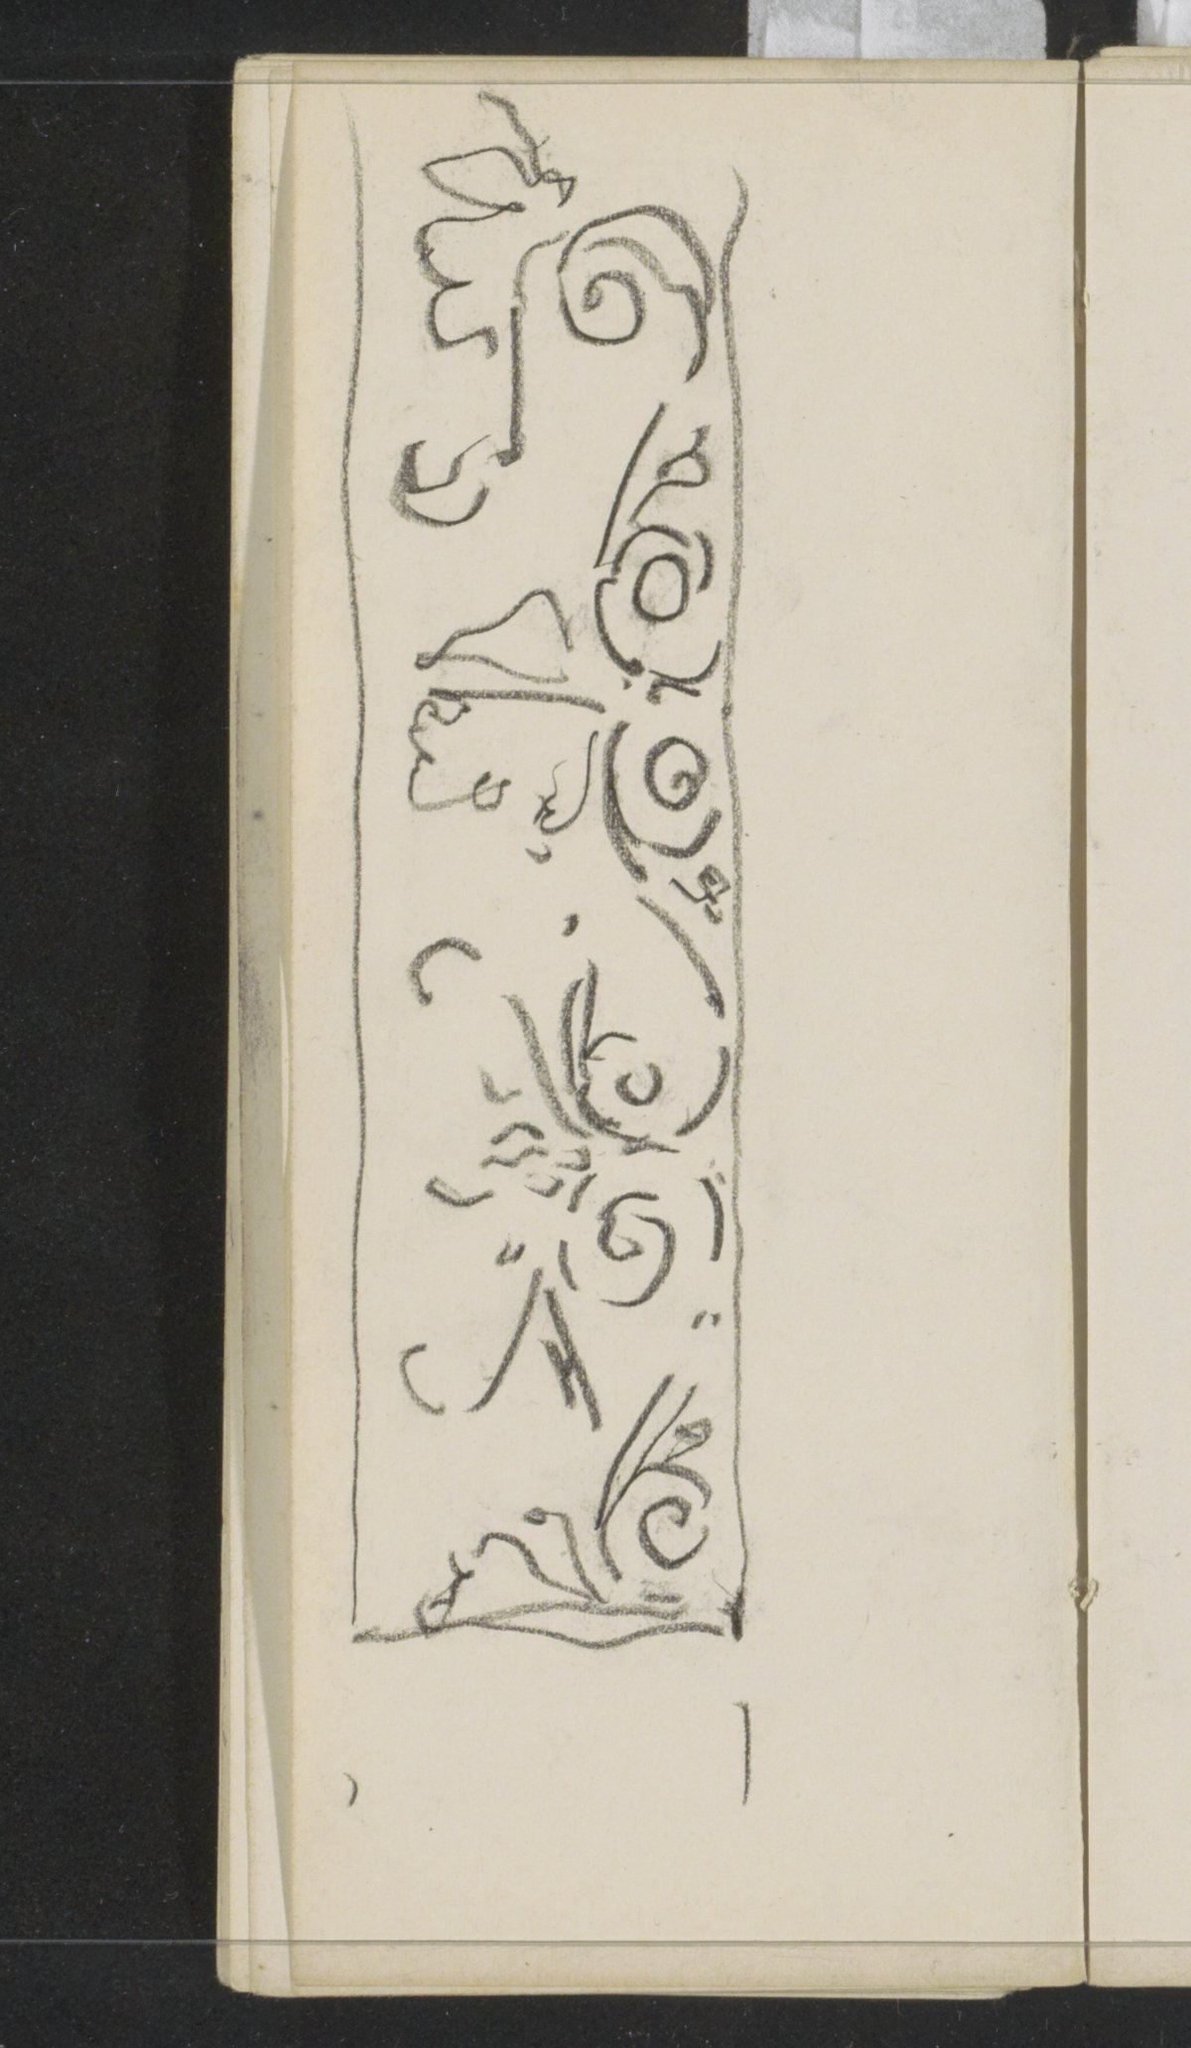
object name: sketchbook leaf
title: Band met een floraal motief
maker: gerrit willem dijsselhof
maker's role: designer, draughtsman, print maker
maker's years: 1866-1924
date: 1901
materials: chalk, paper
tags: flowers ~ ornament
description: Blad 15 verso uit een schetsboek met 42 bladzijden.